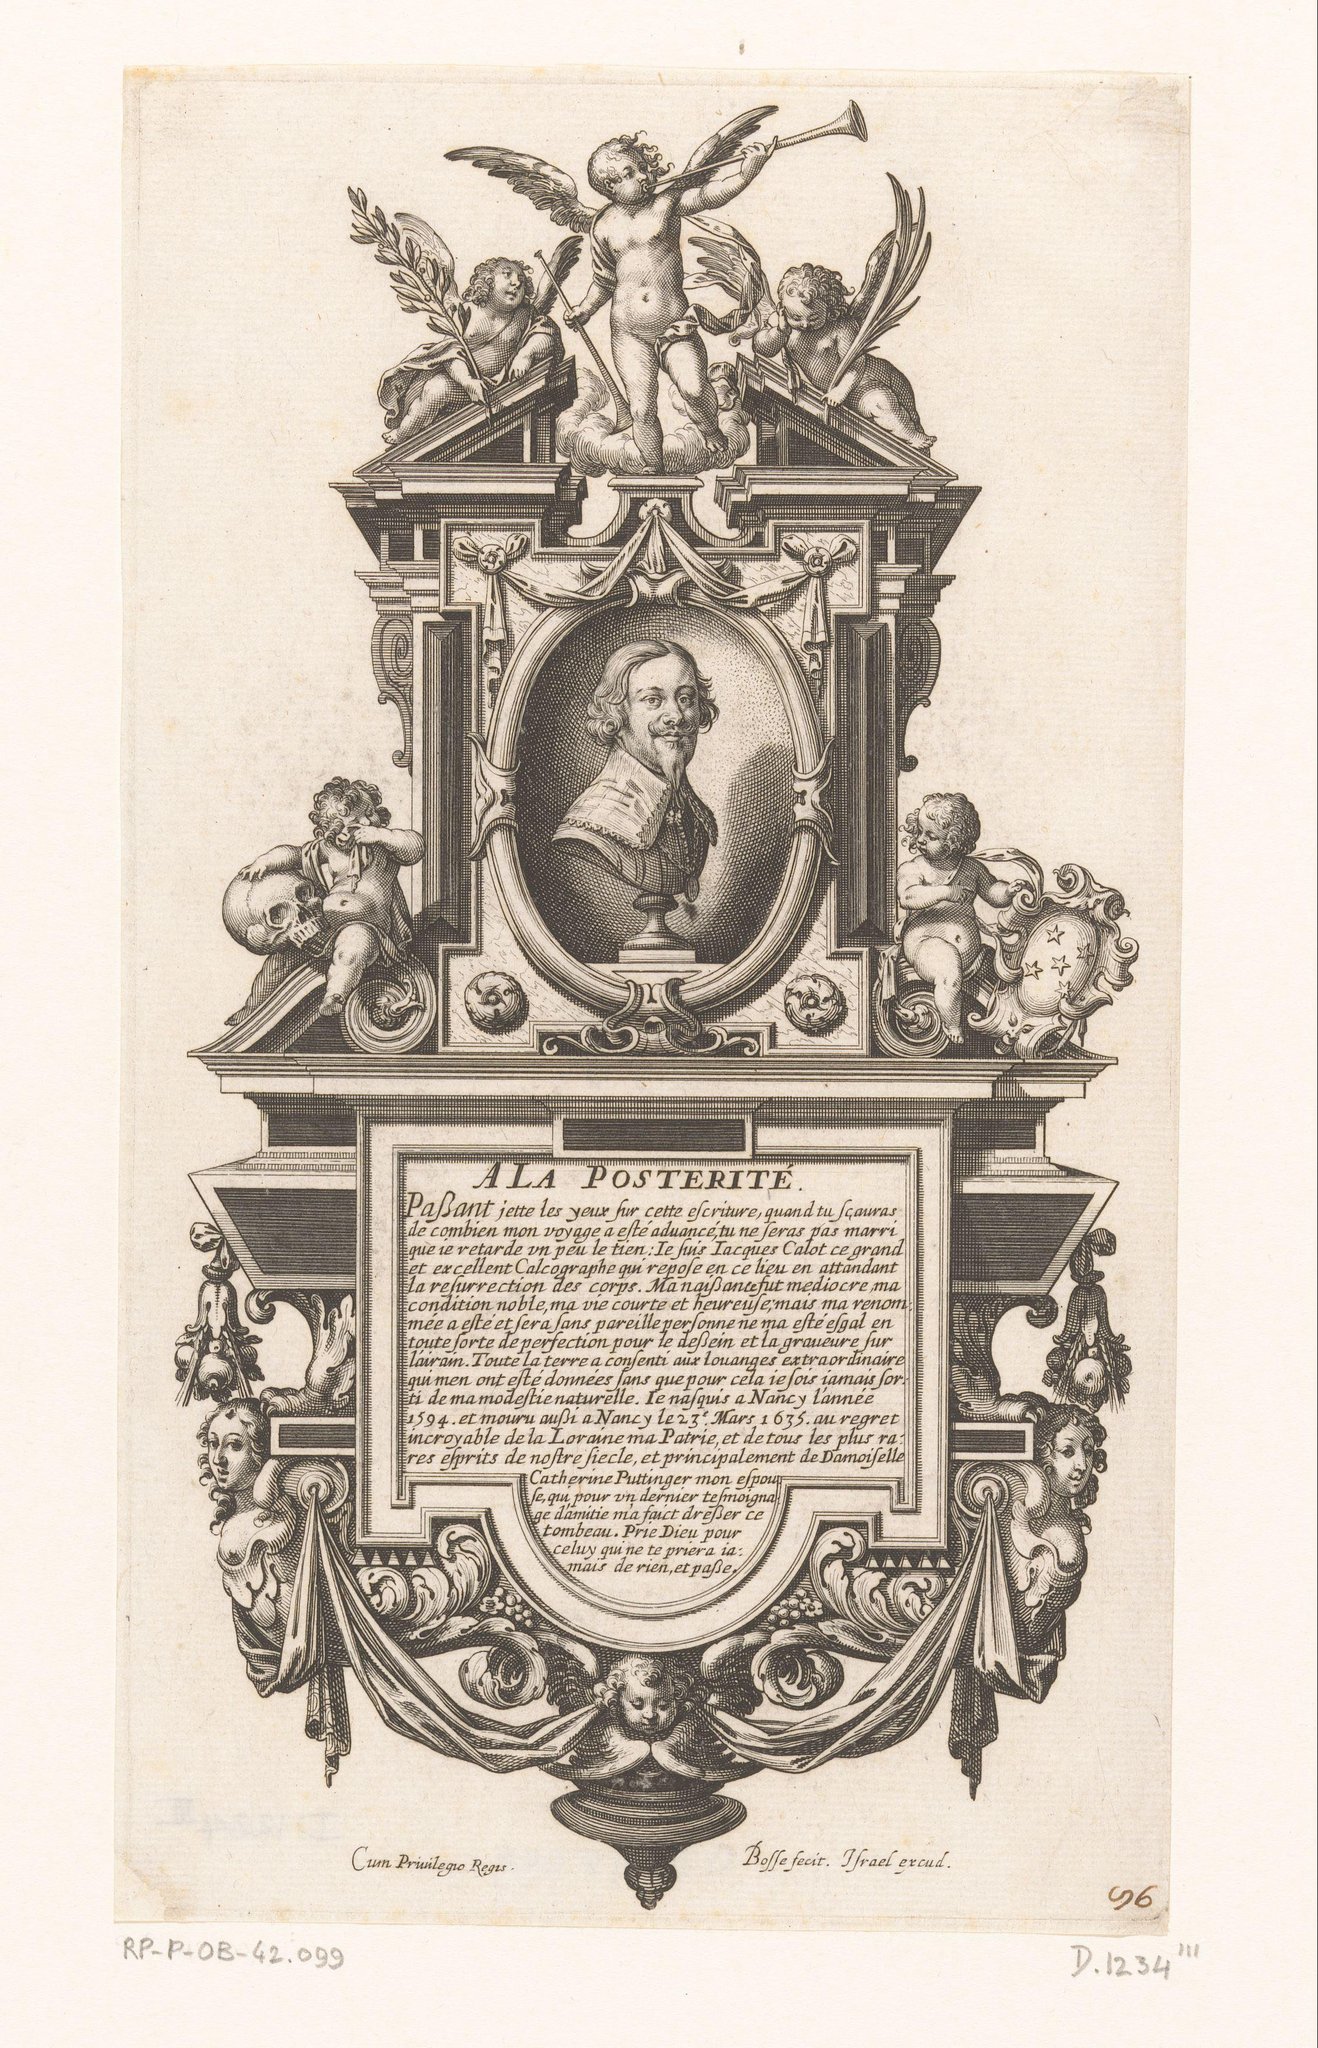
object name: print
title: Epitaaf voor Jacques Callot met portretbuste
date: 1636-1637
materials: paper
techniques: engraving, etching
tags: print maker, draughtsman, jacques callot, historical persons, 'vanitas' symbols, ornament ~ cartouche, portrait, self-portrait of artist, cupids: 'amores', 'amoretti', 'putti'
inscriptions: collector's mark: Lugt 240, number: ‘96’